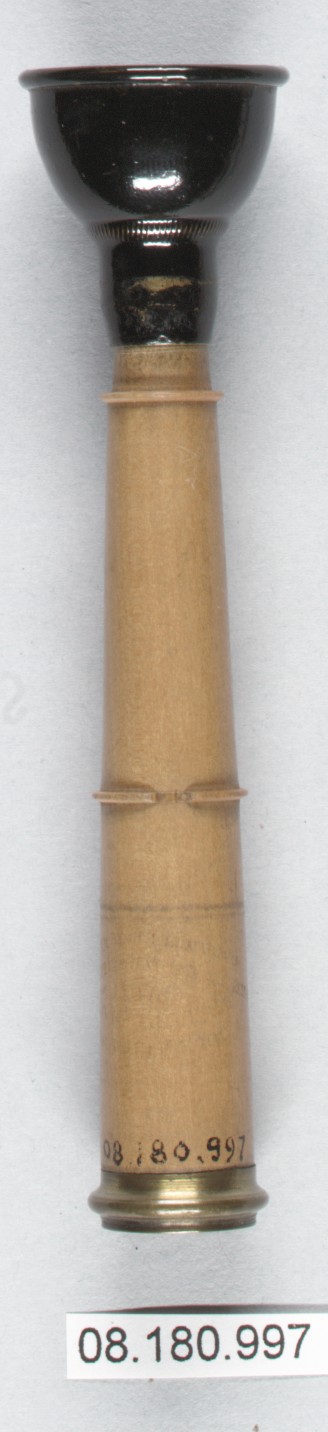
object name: bobbin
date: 1801-1900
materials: plastic, wood